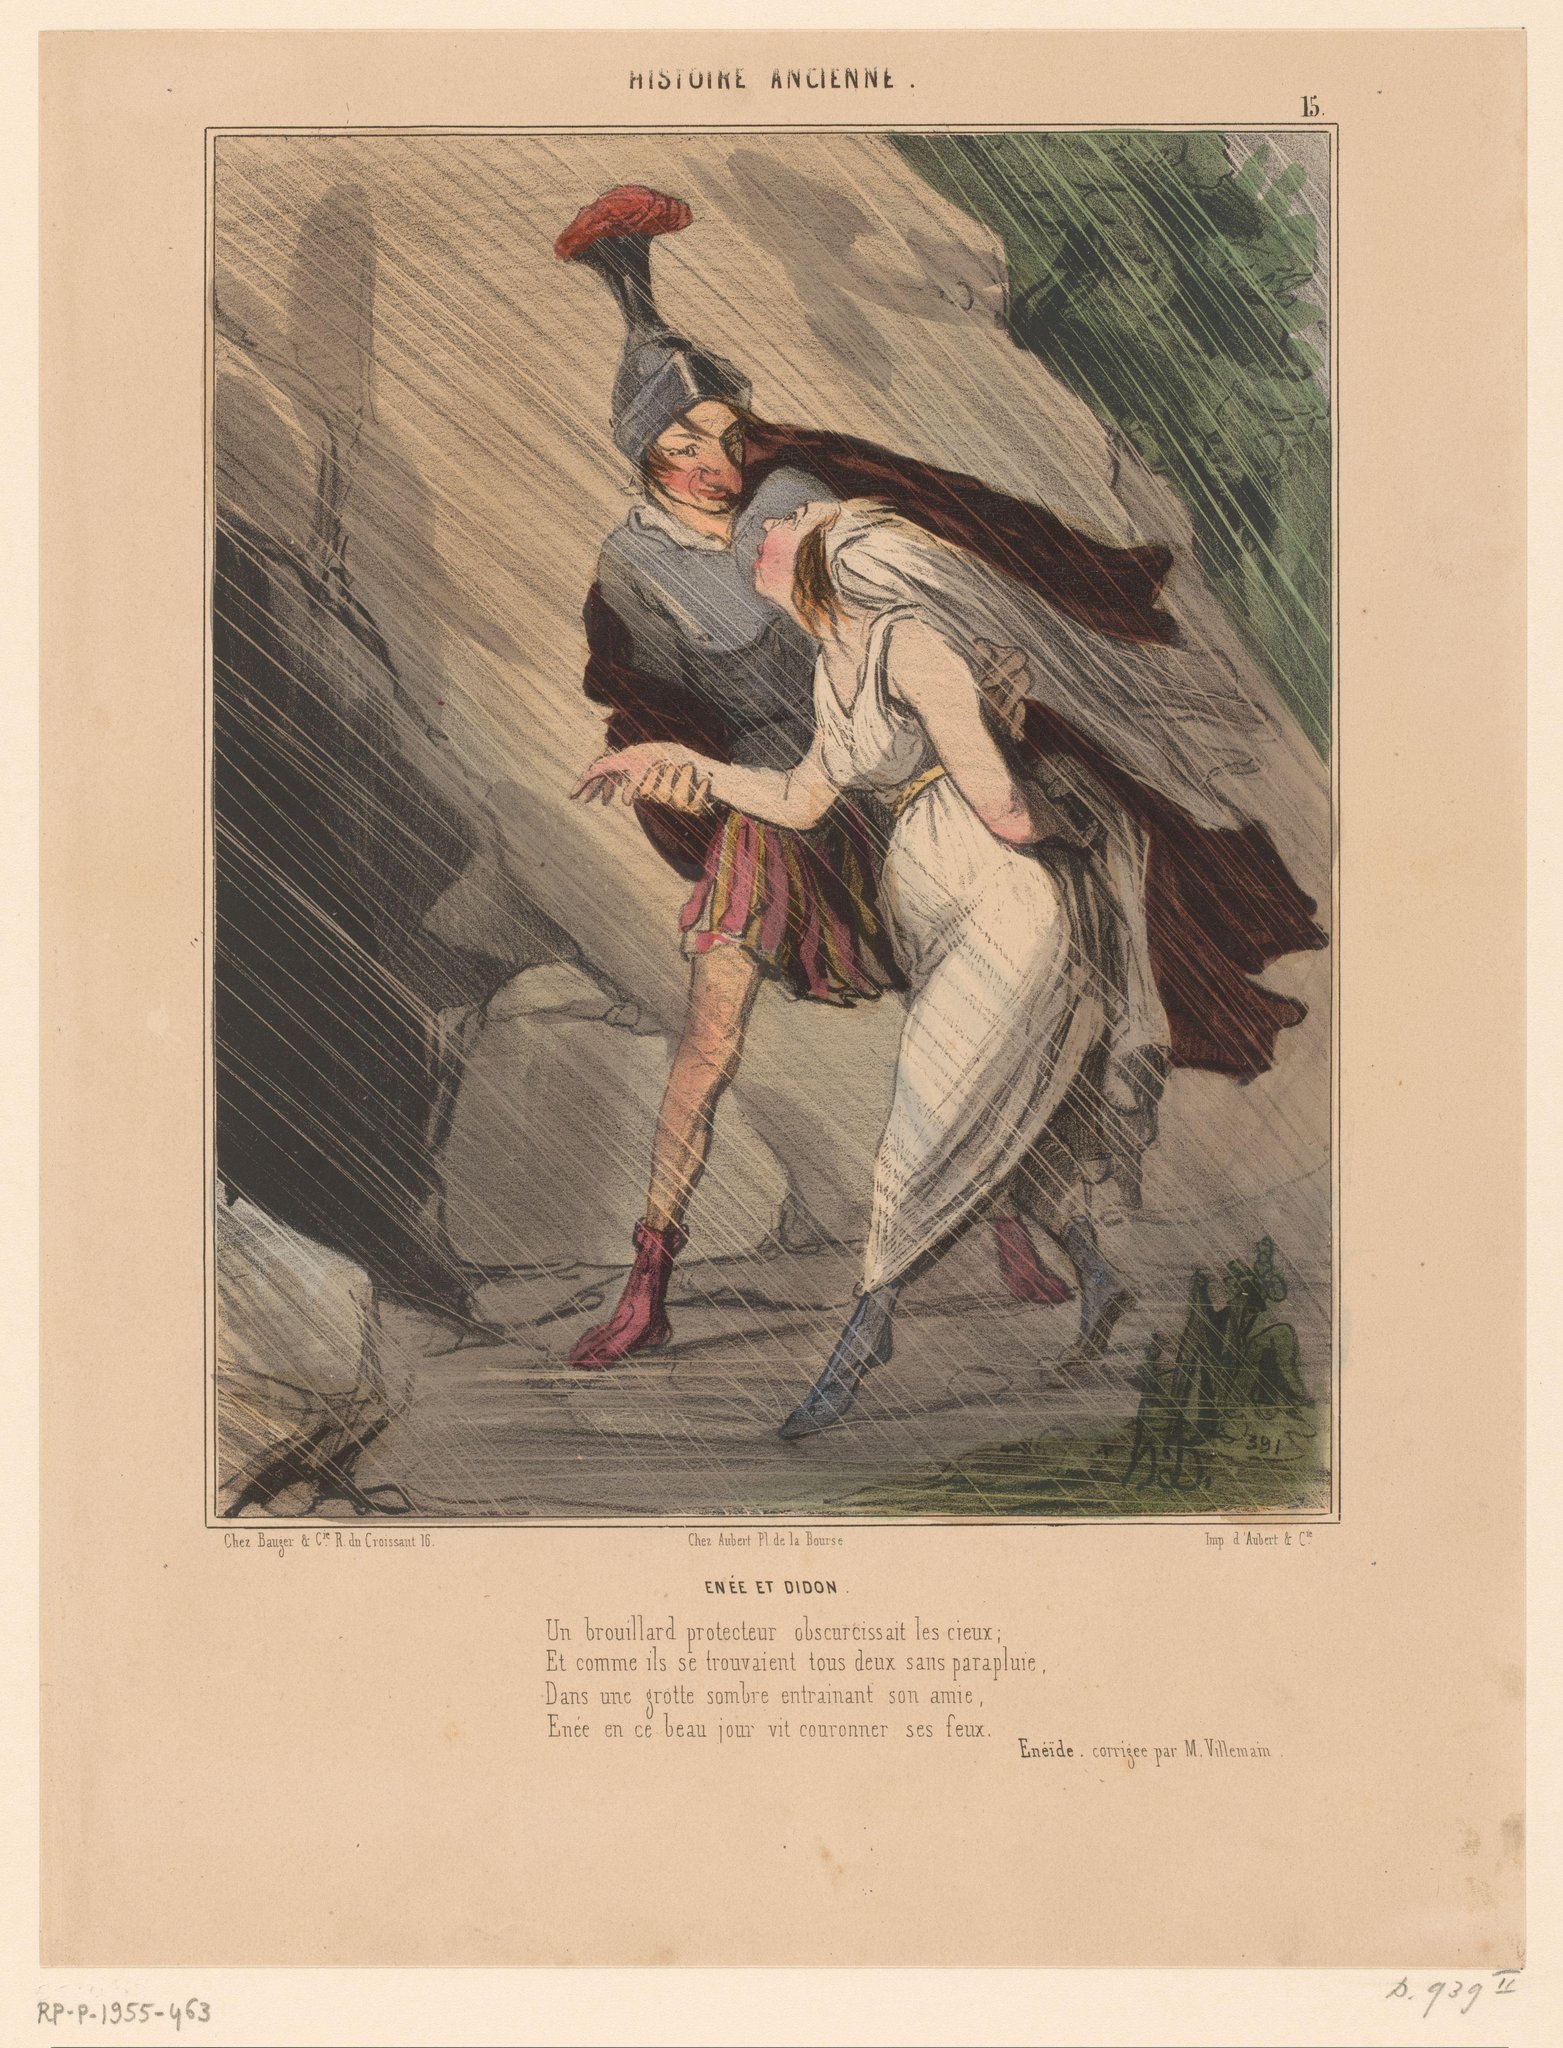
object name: cartoon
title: Enée et Didon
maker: honoré daumier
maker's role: draughtsman, painter, print maker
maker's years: 1808-1879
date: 1842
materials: paper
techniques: hand coloring, lithograph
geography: paris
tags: caricatures (human types), dido and aeneas shelter from the storm in a cave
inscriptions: collector's mark: Lugt 538d, collector's mark: Lugt 2228a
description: Prent gepubliceerd in: Le Charivari, Aubert: Parijs, 03-07-1842. Le Charivari was een humoristische krant met karikaturen en (politieke) cartoons.